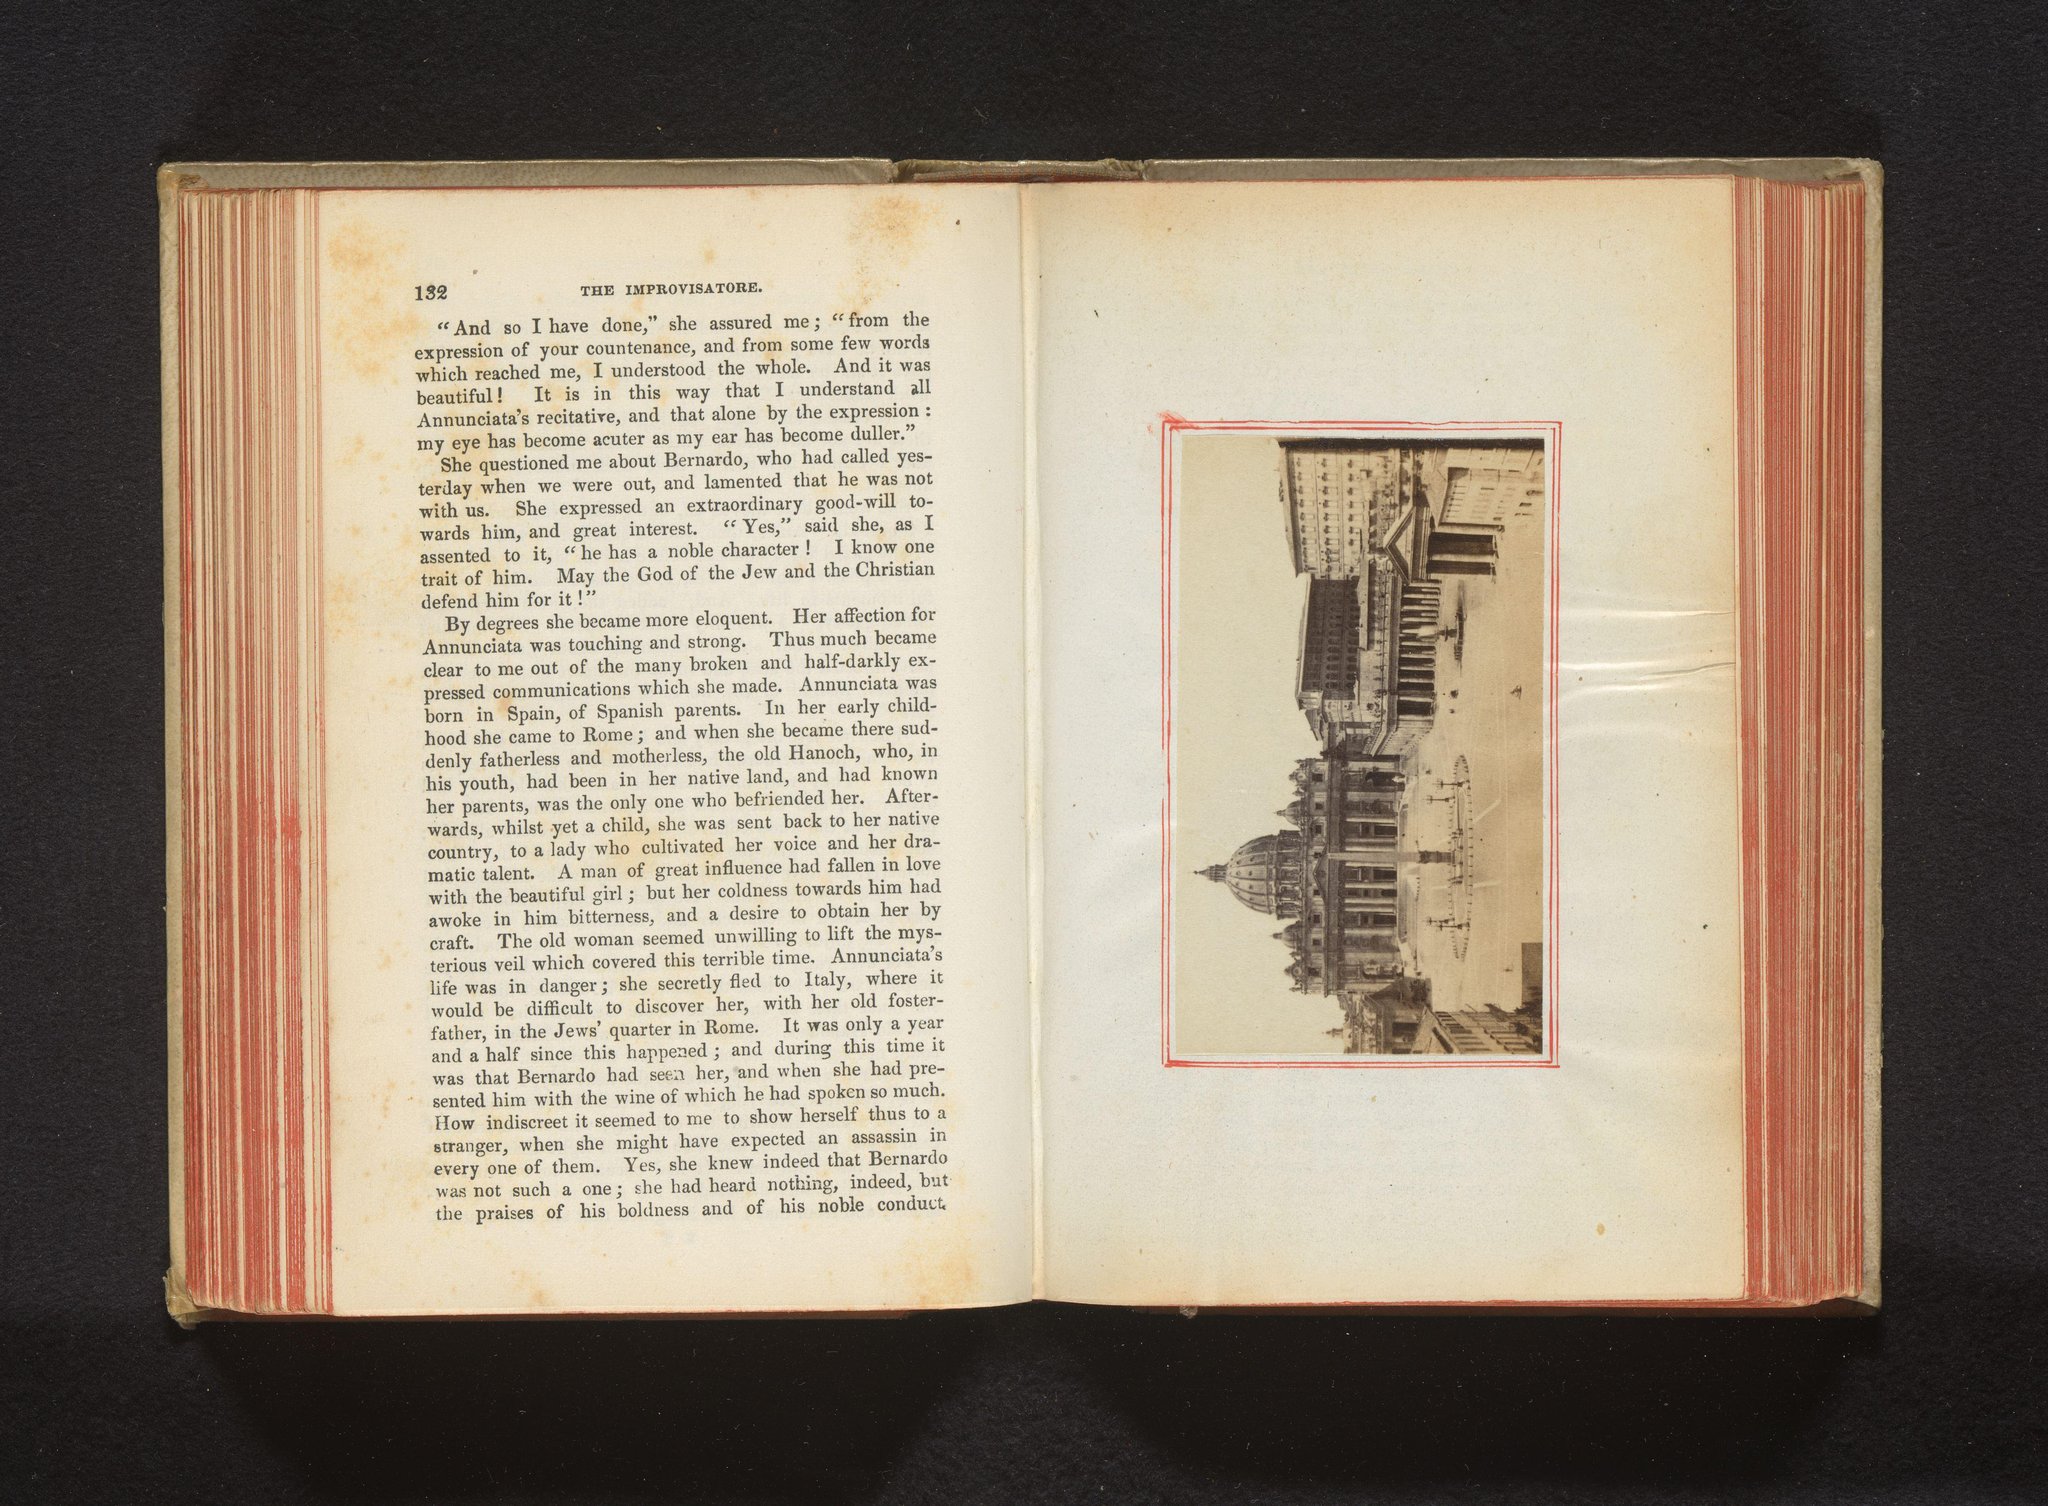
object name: photograph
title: Gezicht op het Sint-Pietersplein te Vaticaanstad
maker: Anonymous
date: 1863-1873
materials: photographic support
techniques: albumen print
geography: rome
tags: square, place, circus, etc., church (exterior), façade (of house or building)